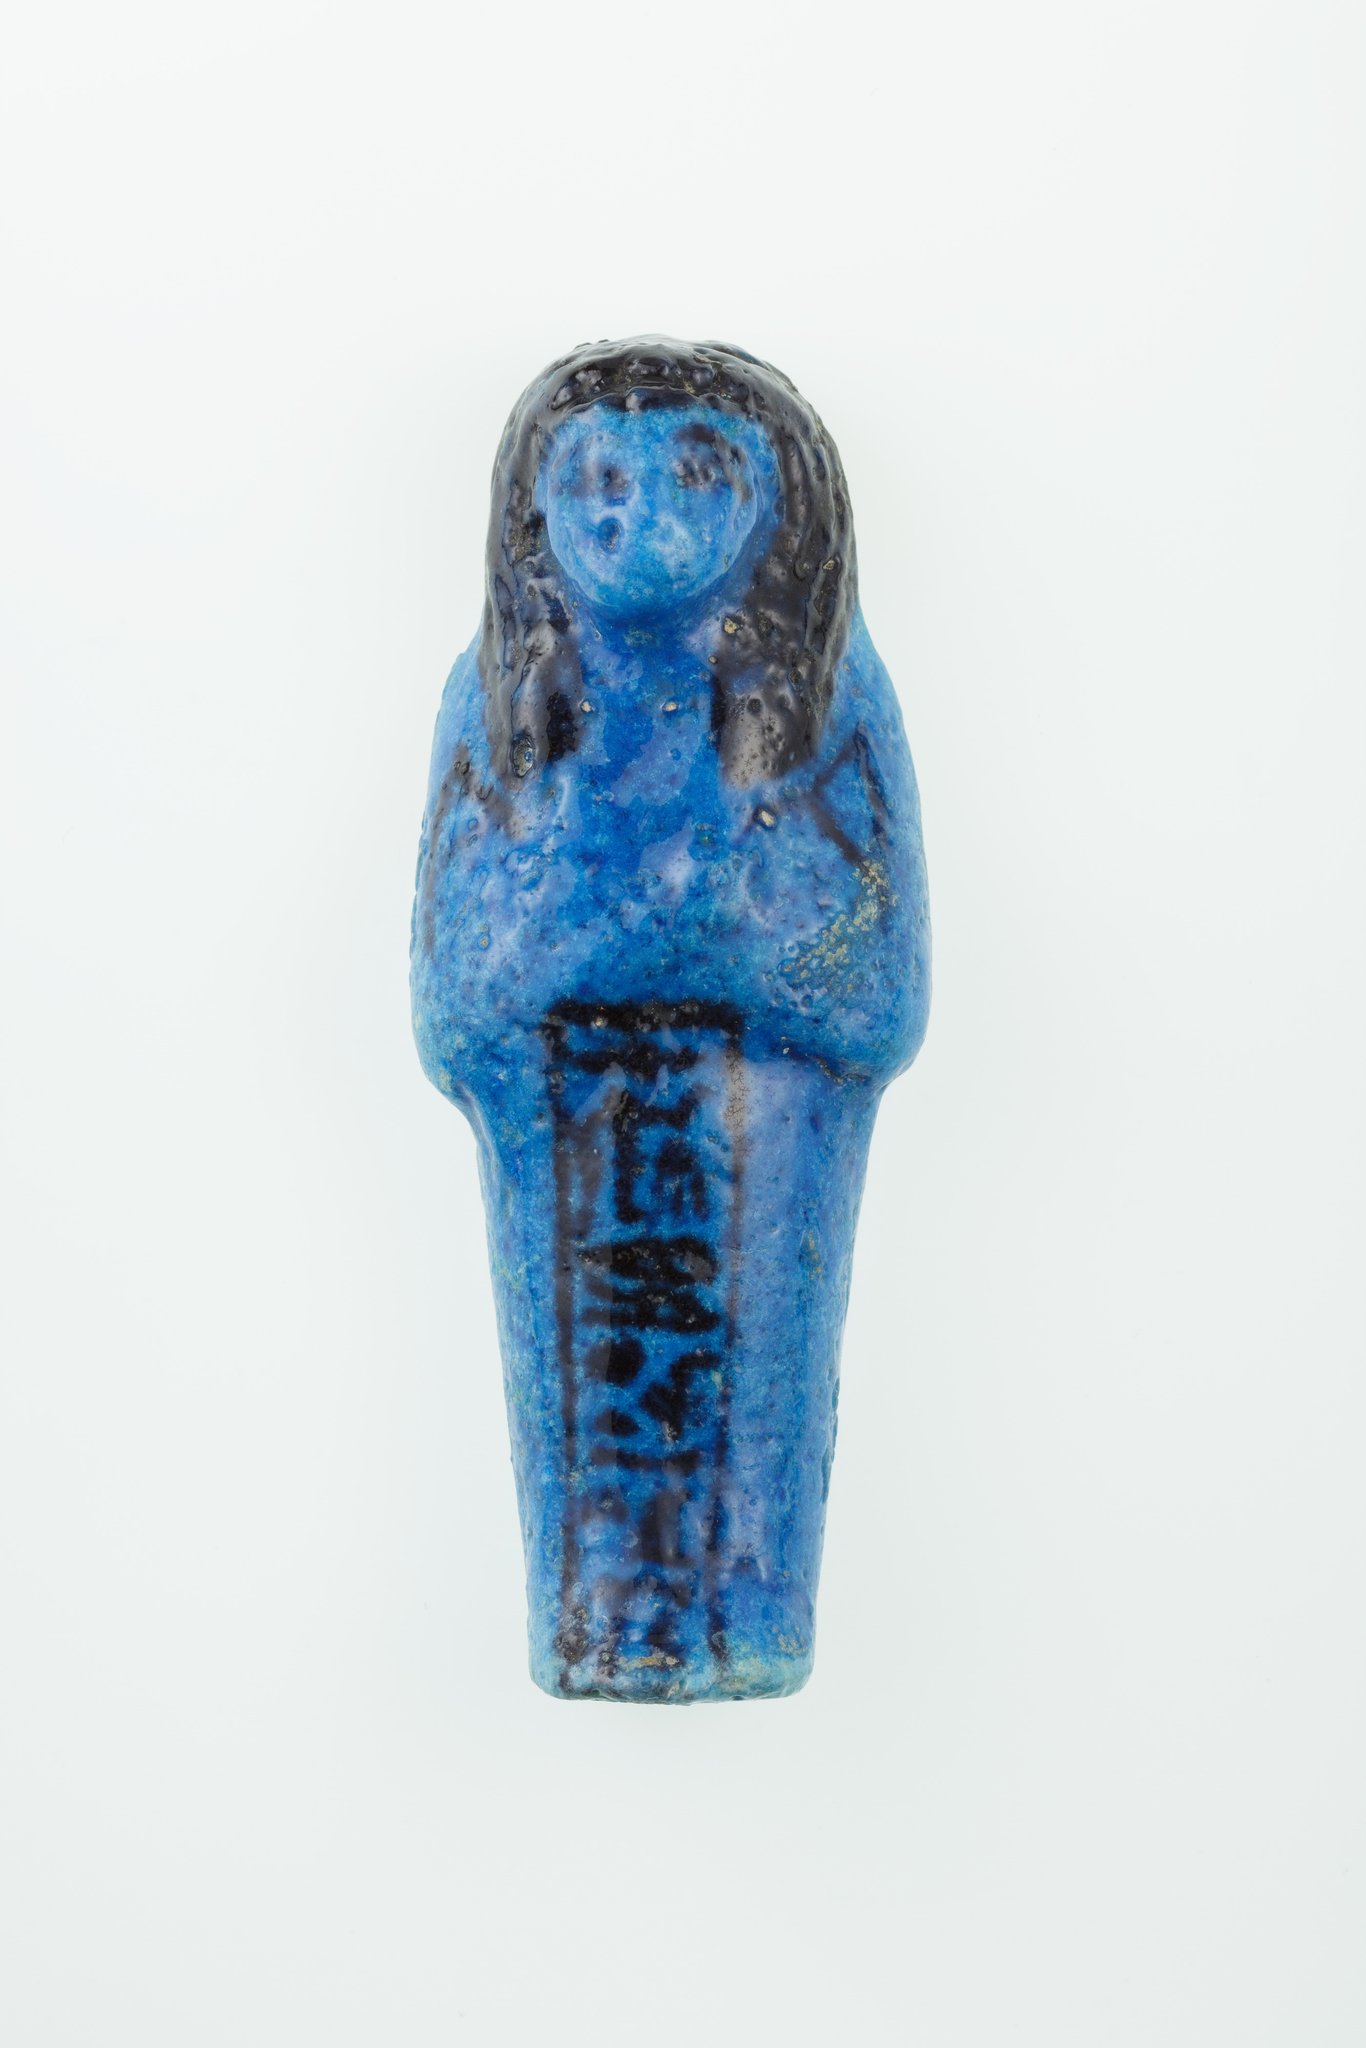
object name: shabti, worker, nauny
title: Worker Shabti of Nauny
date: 1050 BCE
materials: faience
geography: egypt